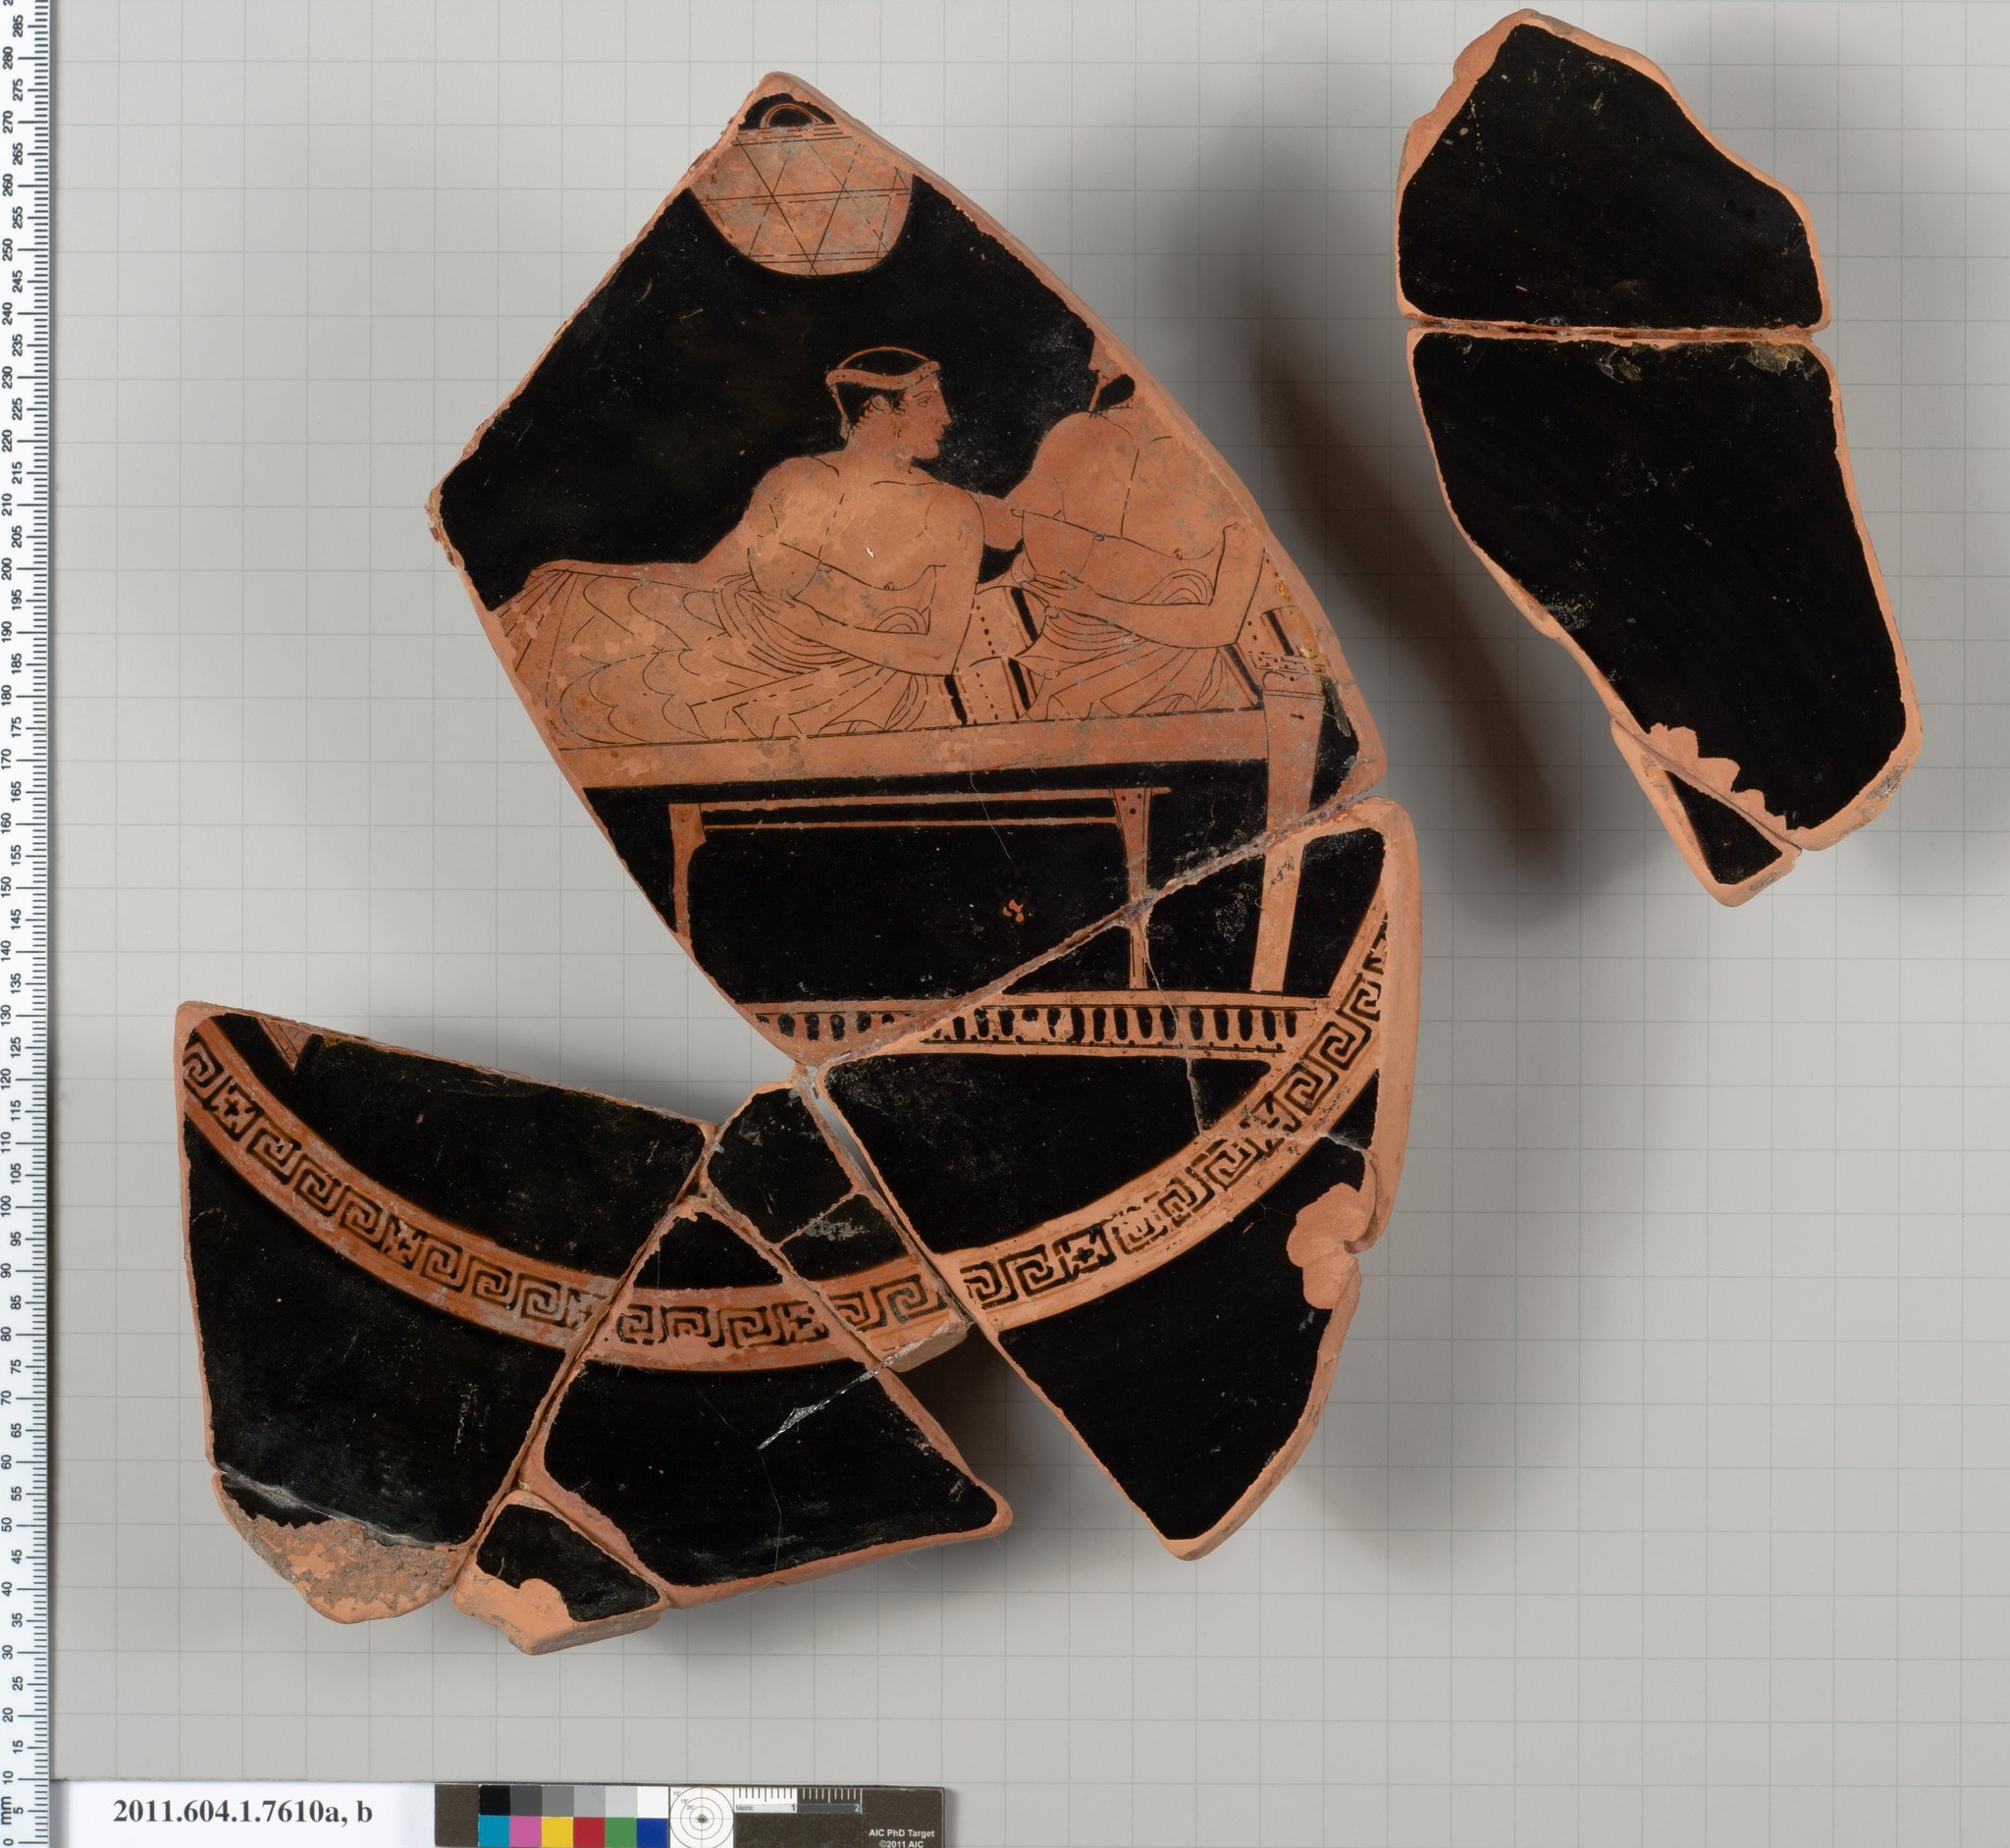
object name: kylix fragment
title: Terracotta fragments of a kylix (drinking cup)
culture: greek, attic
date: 460-450 BCE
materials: terracotta